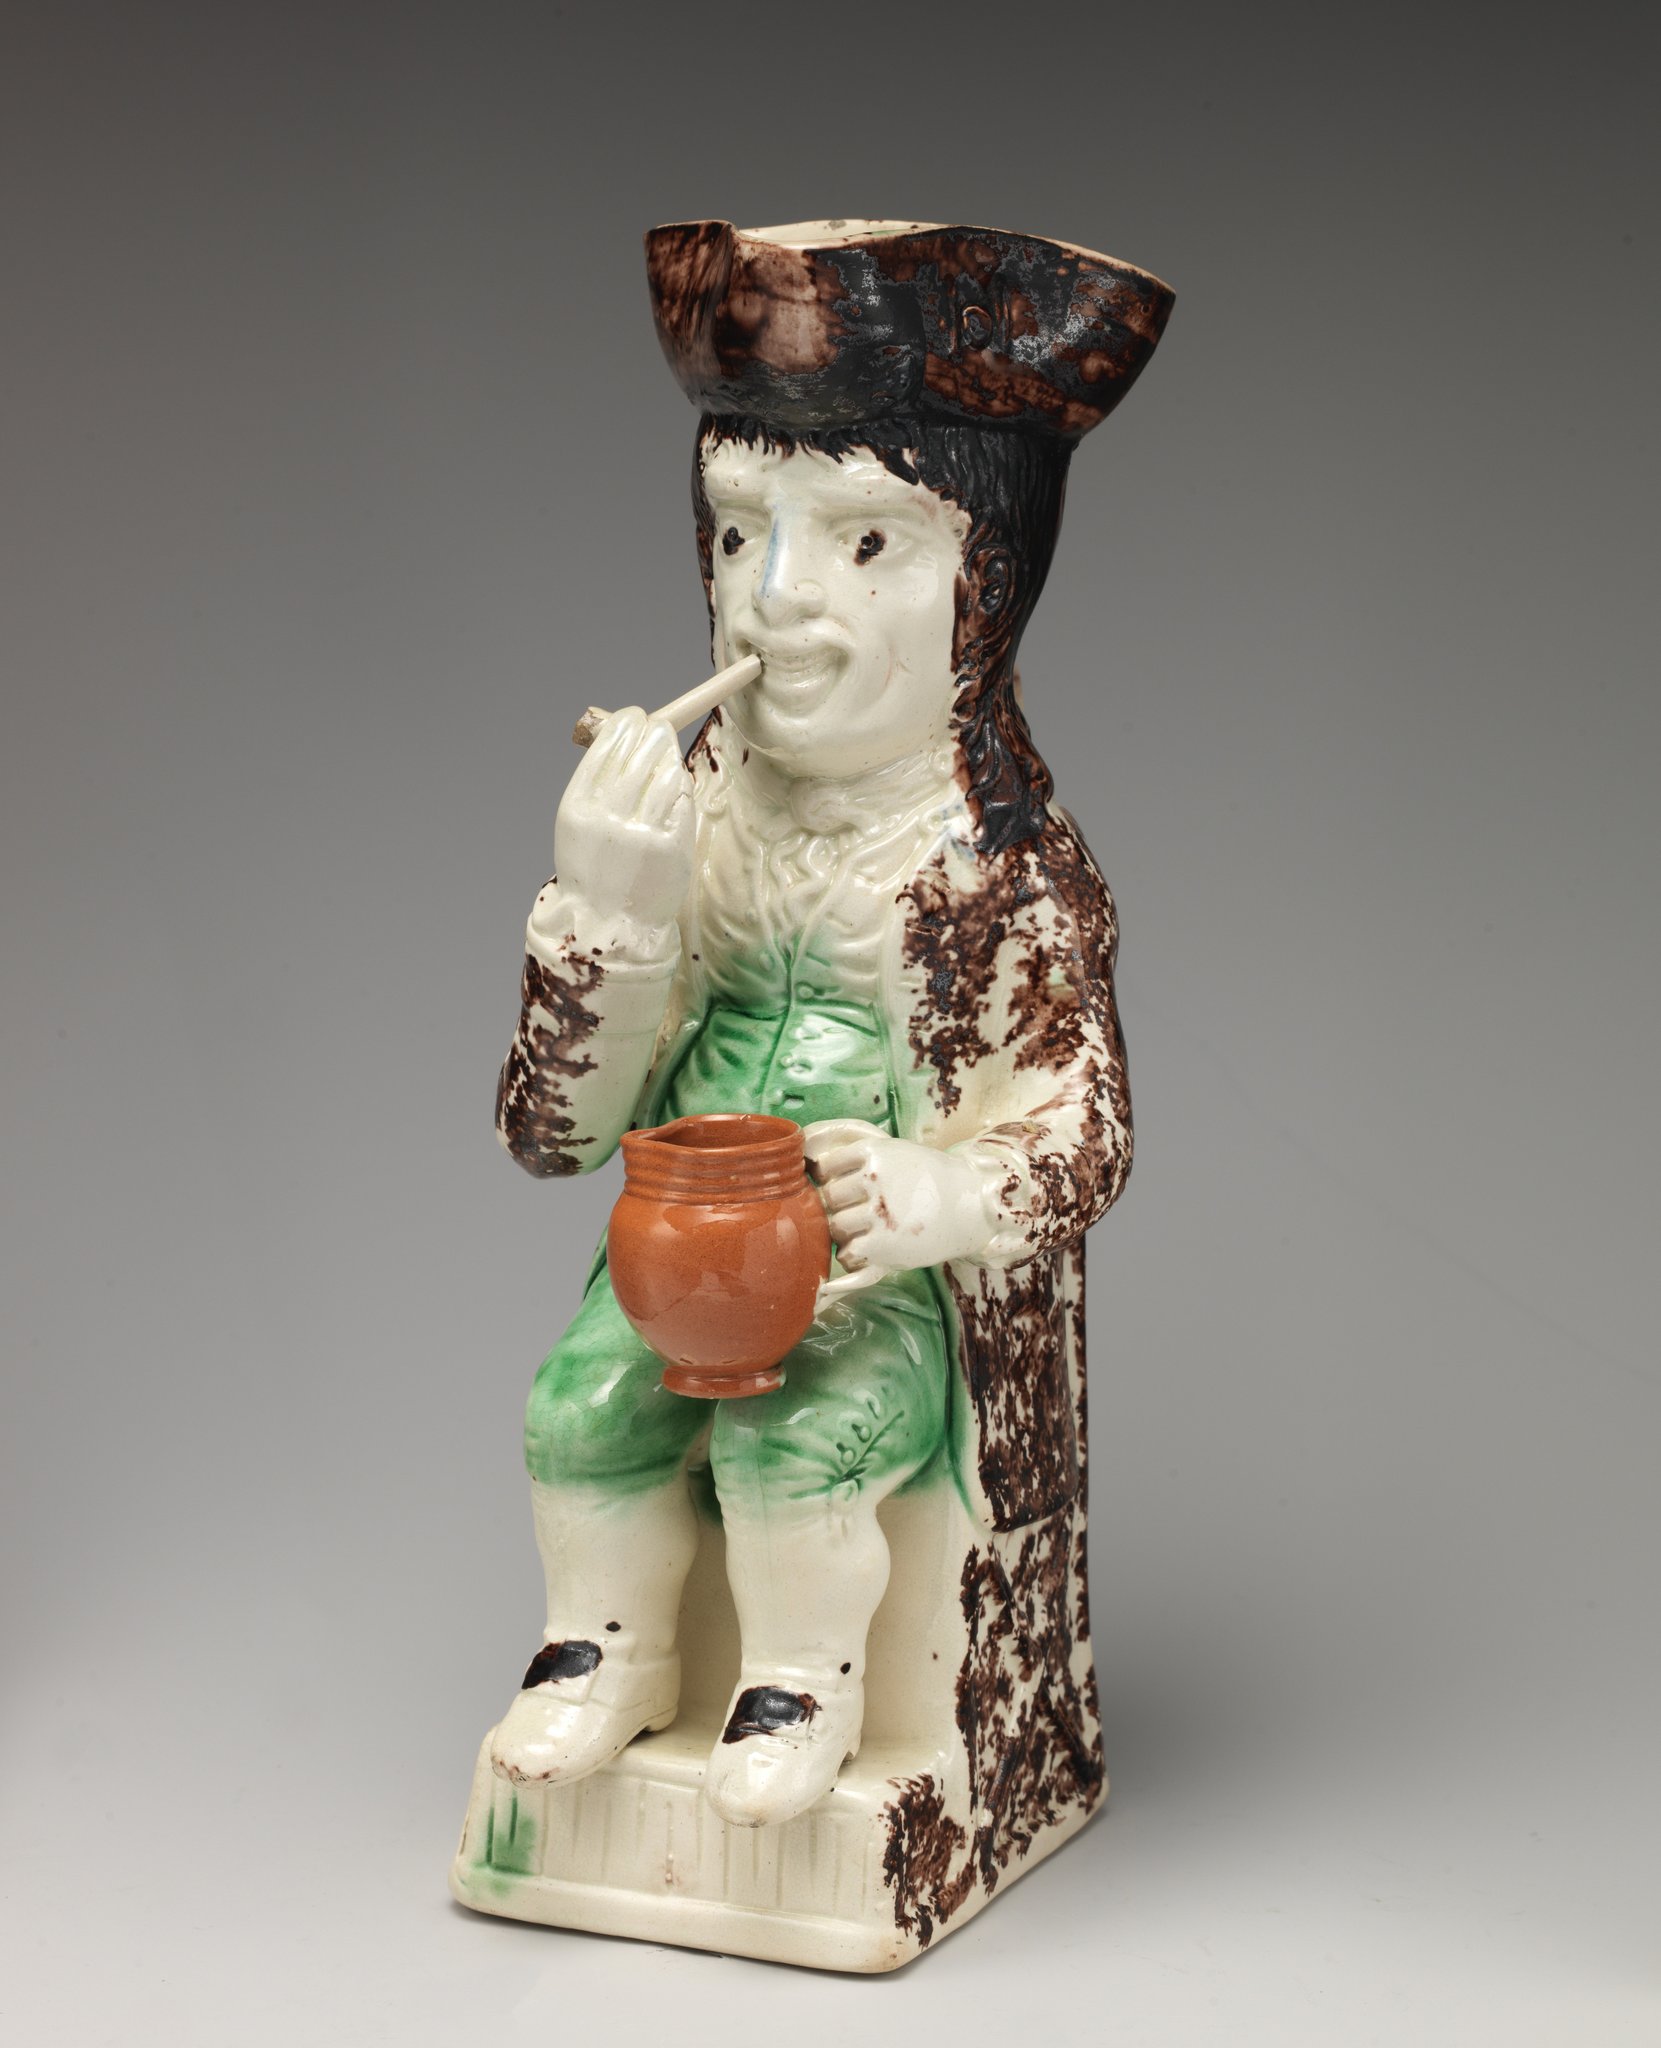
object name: toby jug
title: "The Thin Man"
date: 1770-1780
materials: earthenware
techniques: glazing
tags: men